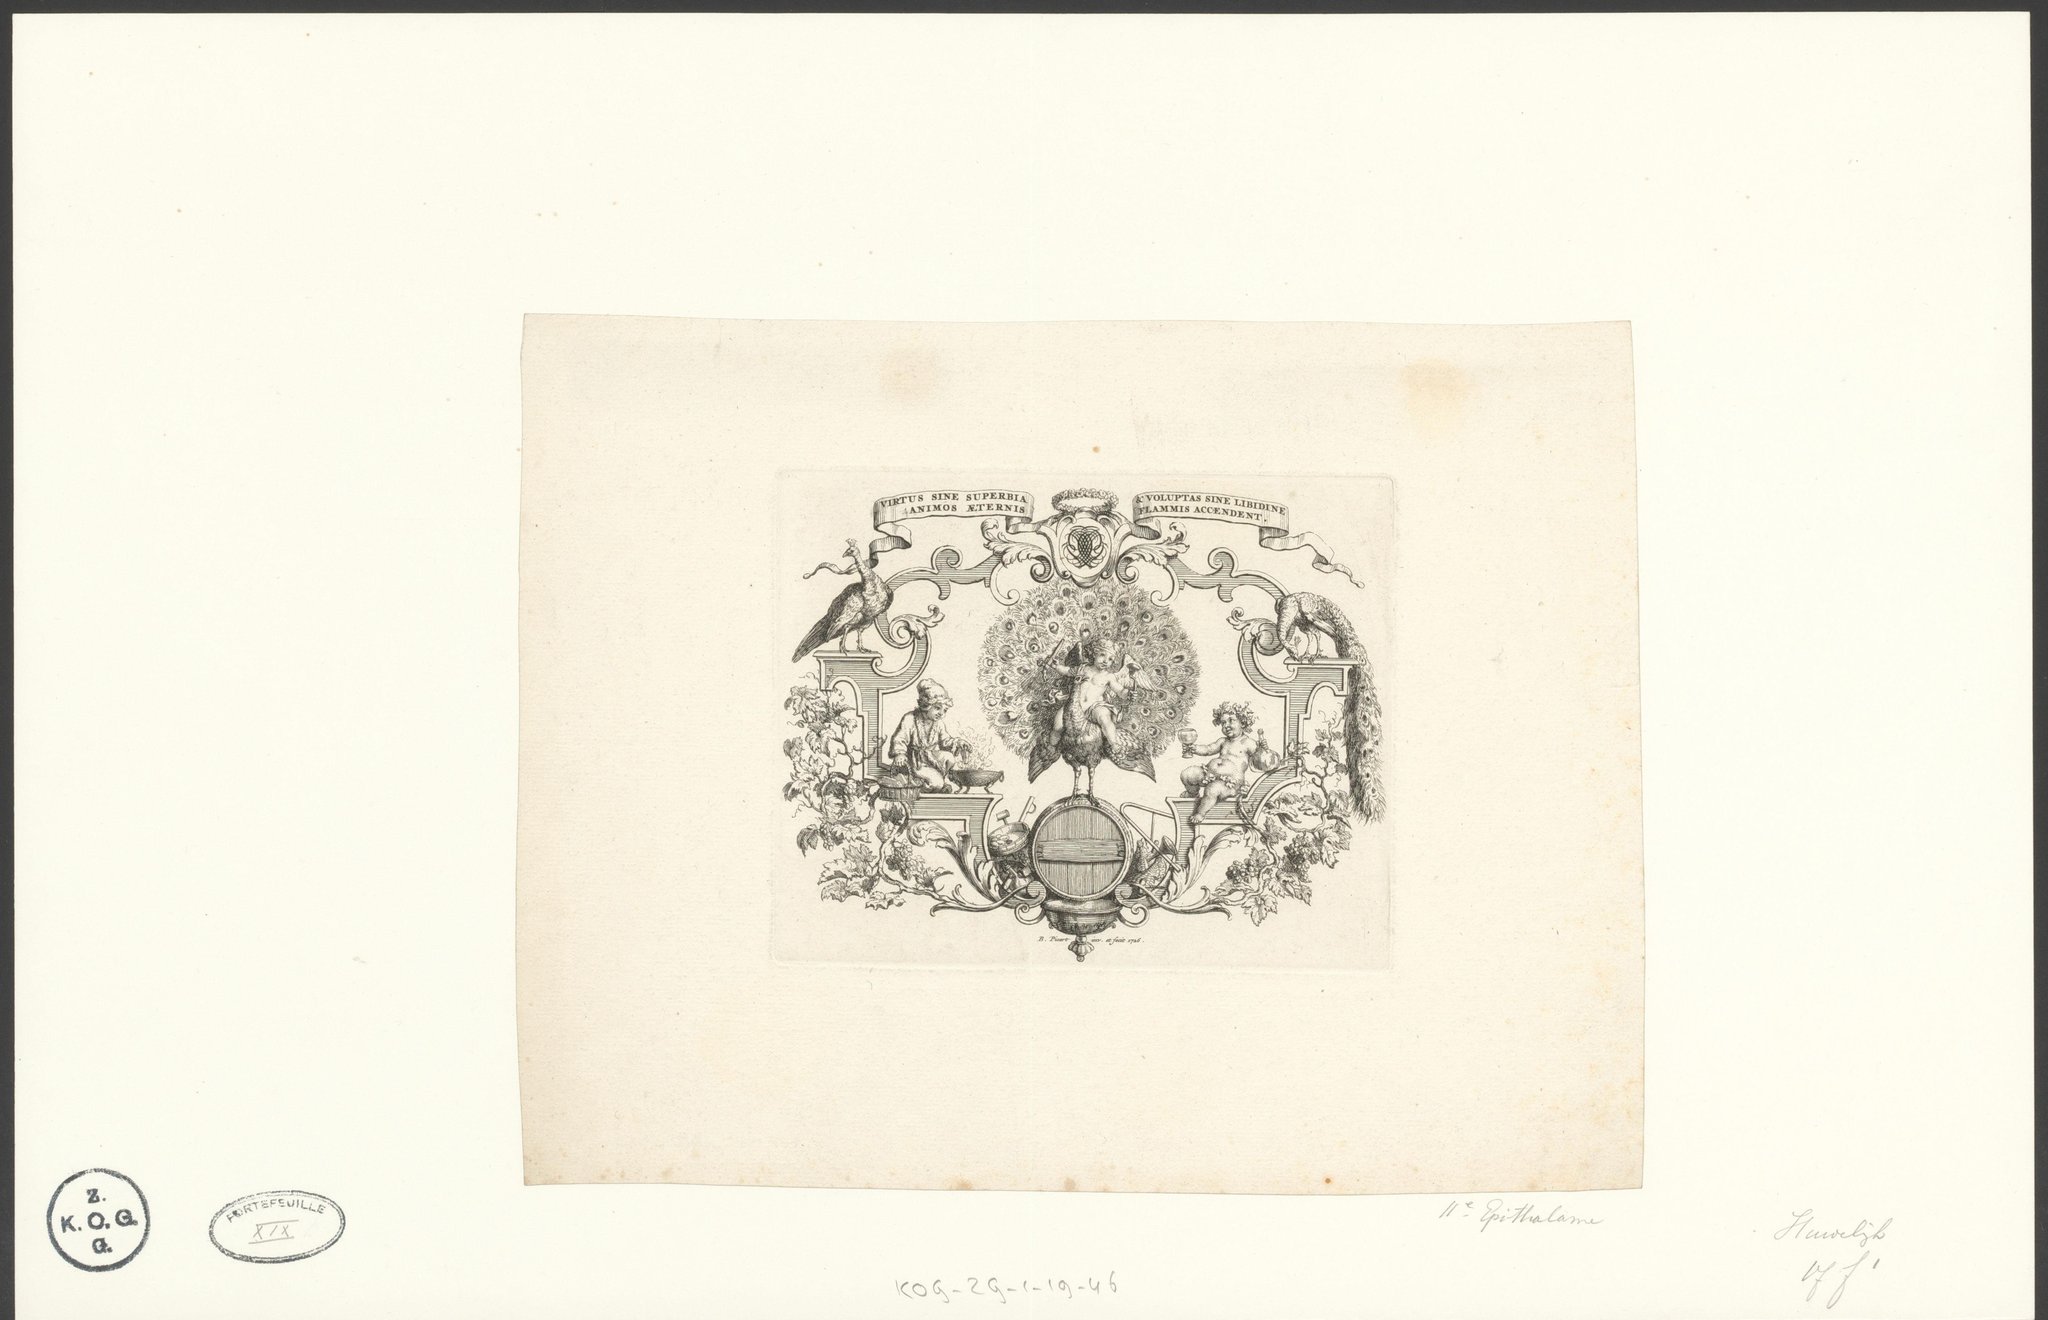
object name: print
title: Bruiloftsprent, 1726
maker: bernard picart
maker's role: draughtsman, print maker, publisher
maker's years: 1673-1733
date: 1726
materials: paper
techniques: engraving, etching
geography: netherlands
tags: children's bacchanal, ornamental birds: peacock, glass of wine, alchemist at work, (civil) marriage ceremonies, viticulture, wine-growing; vintage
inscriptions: collector's mark, collector's mark: Lugt 1641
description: Bruiloftsprent uit 1726 met een allegorische voorstelling van Cupido gezeten op een pauw dat staat op een wijnvat. Links en rechts nog twee pauwen. Links een kind alchemist en rechts een Bacchus kind met wijnglas. Bovenaan de spreuk 'Virtus sine superbia & voluptas sine libidine animos aeternis flammis accendent' en geïntegreerde monogrammen. De onderste helft versierd met wijnranken. Onderwerpsrubrieken binnen de Atlas Zeden en Gewoonten: Des Menschen Begin, Midden en Einde. Bruiloft en huwelijk.